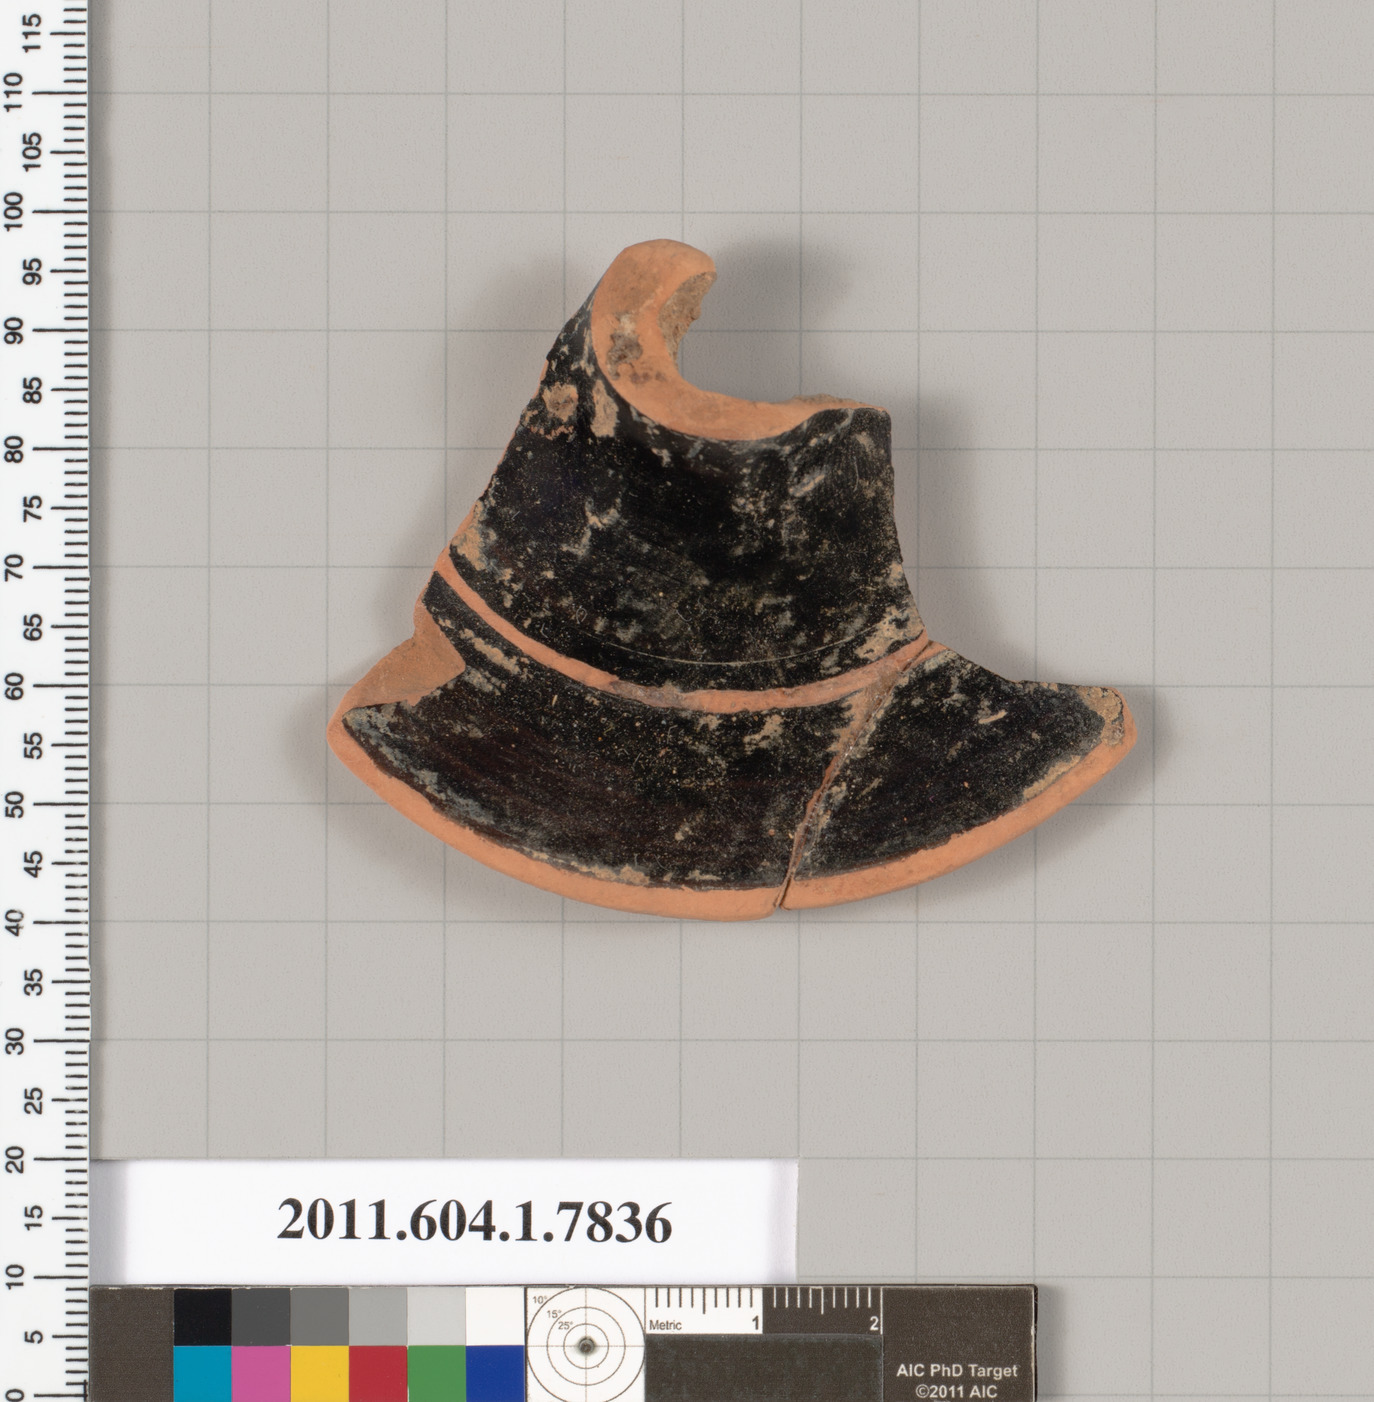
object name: kylix fragment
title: Terracotta fragment of a kylix (drinking cup)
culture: greek, attic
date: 460-450 BCE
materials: terracotta